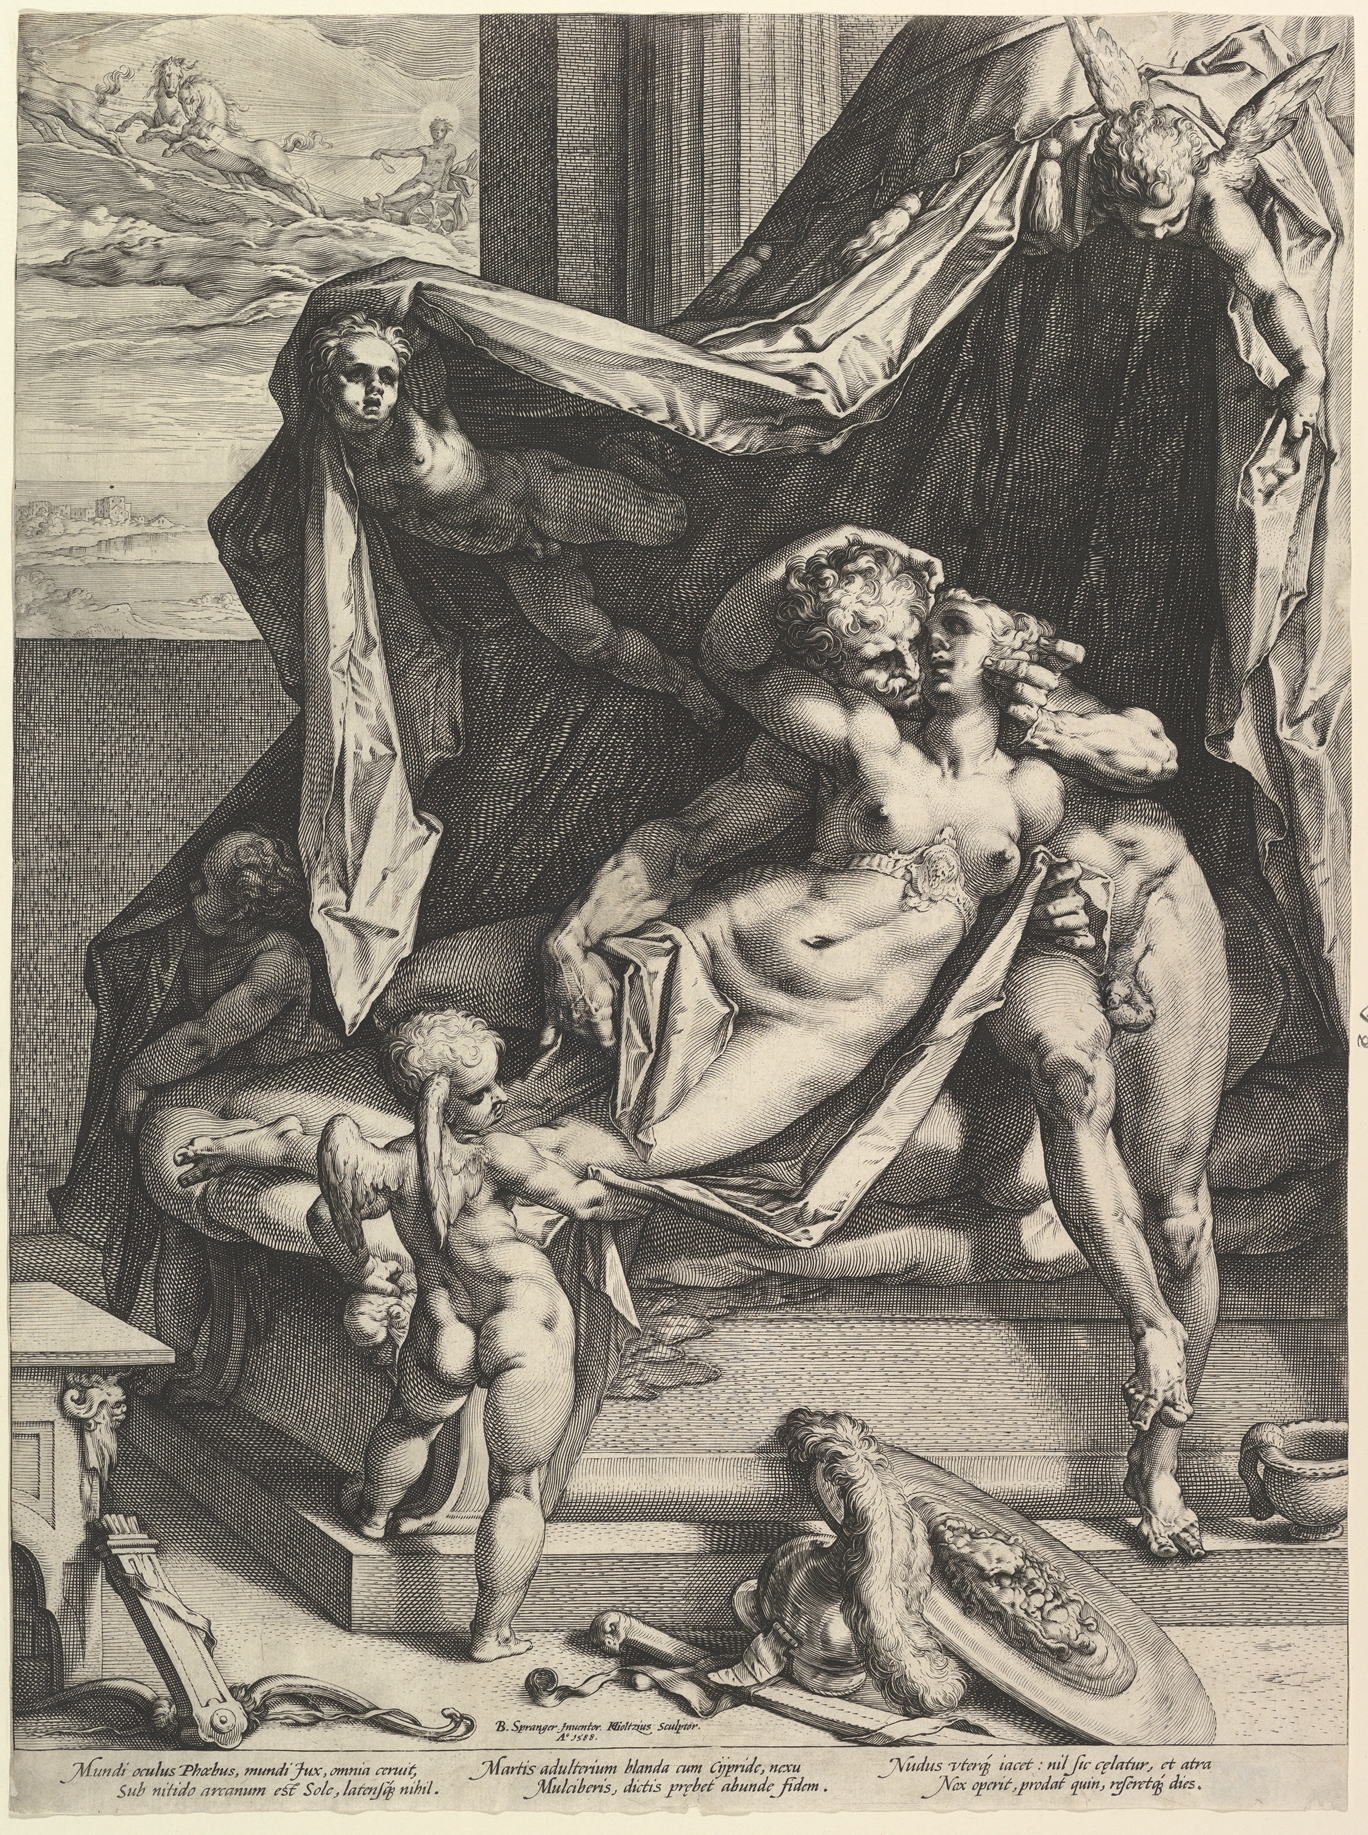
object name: print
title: Mars and Venus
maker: hendrick goltzius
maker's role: artist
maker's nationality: netherlandish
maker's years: 1558-1617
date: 1588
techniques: engraving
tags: mars,venus